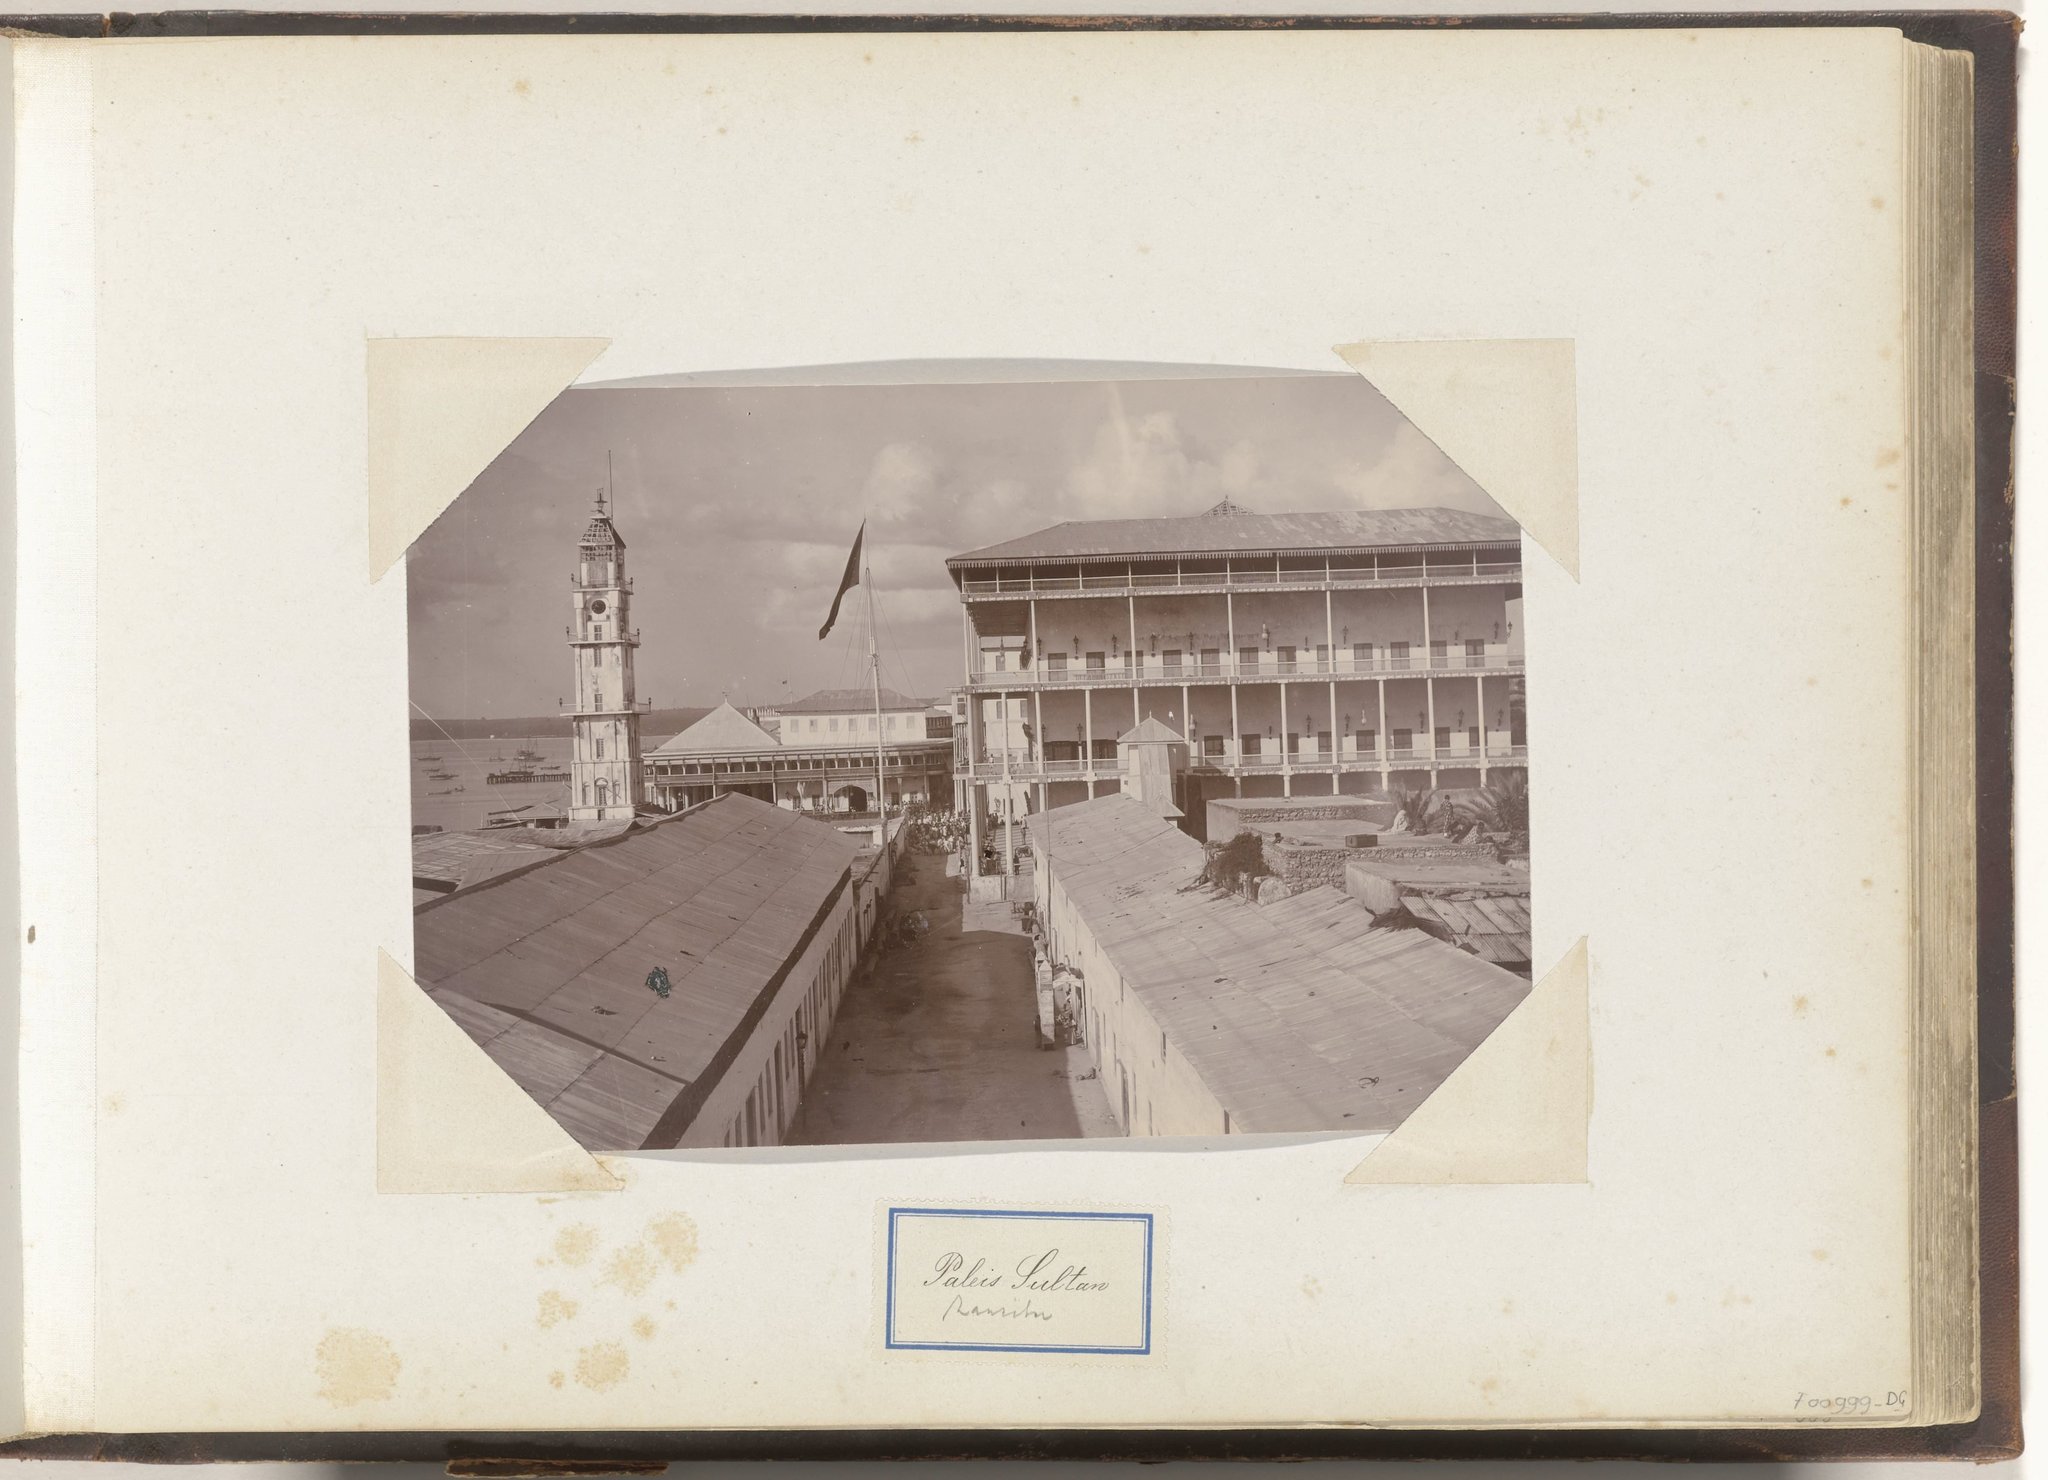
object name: photograph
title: Paleis Sultan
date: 1900-1920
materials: paper, photographic support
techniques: gelatin silver print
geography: zanzibar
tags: palace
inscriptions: stamp: ‘Coutinho Bros. Photographers Zanzibar’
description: Onderdeel van Album met 191 foto's van een reis naar en door Zuid-Afrika.